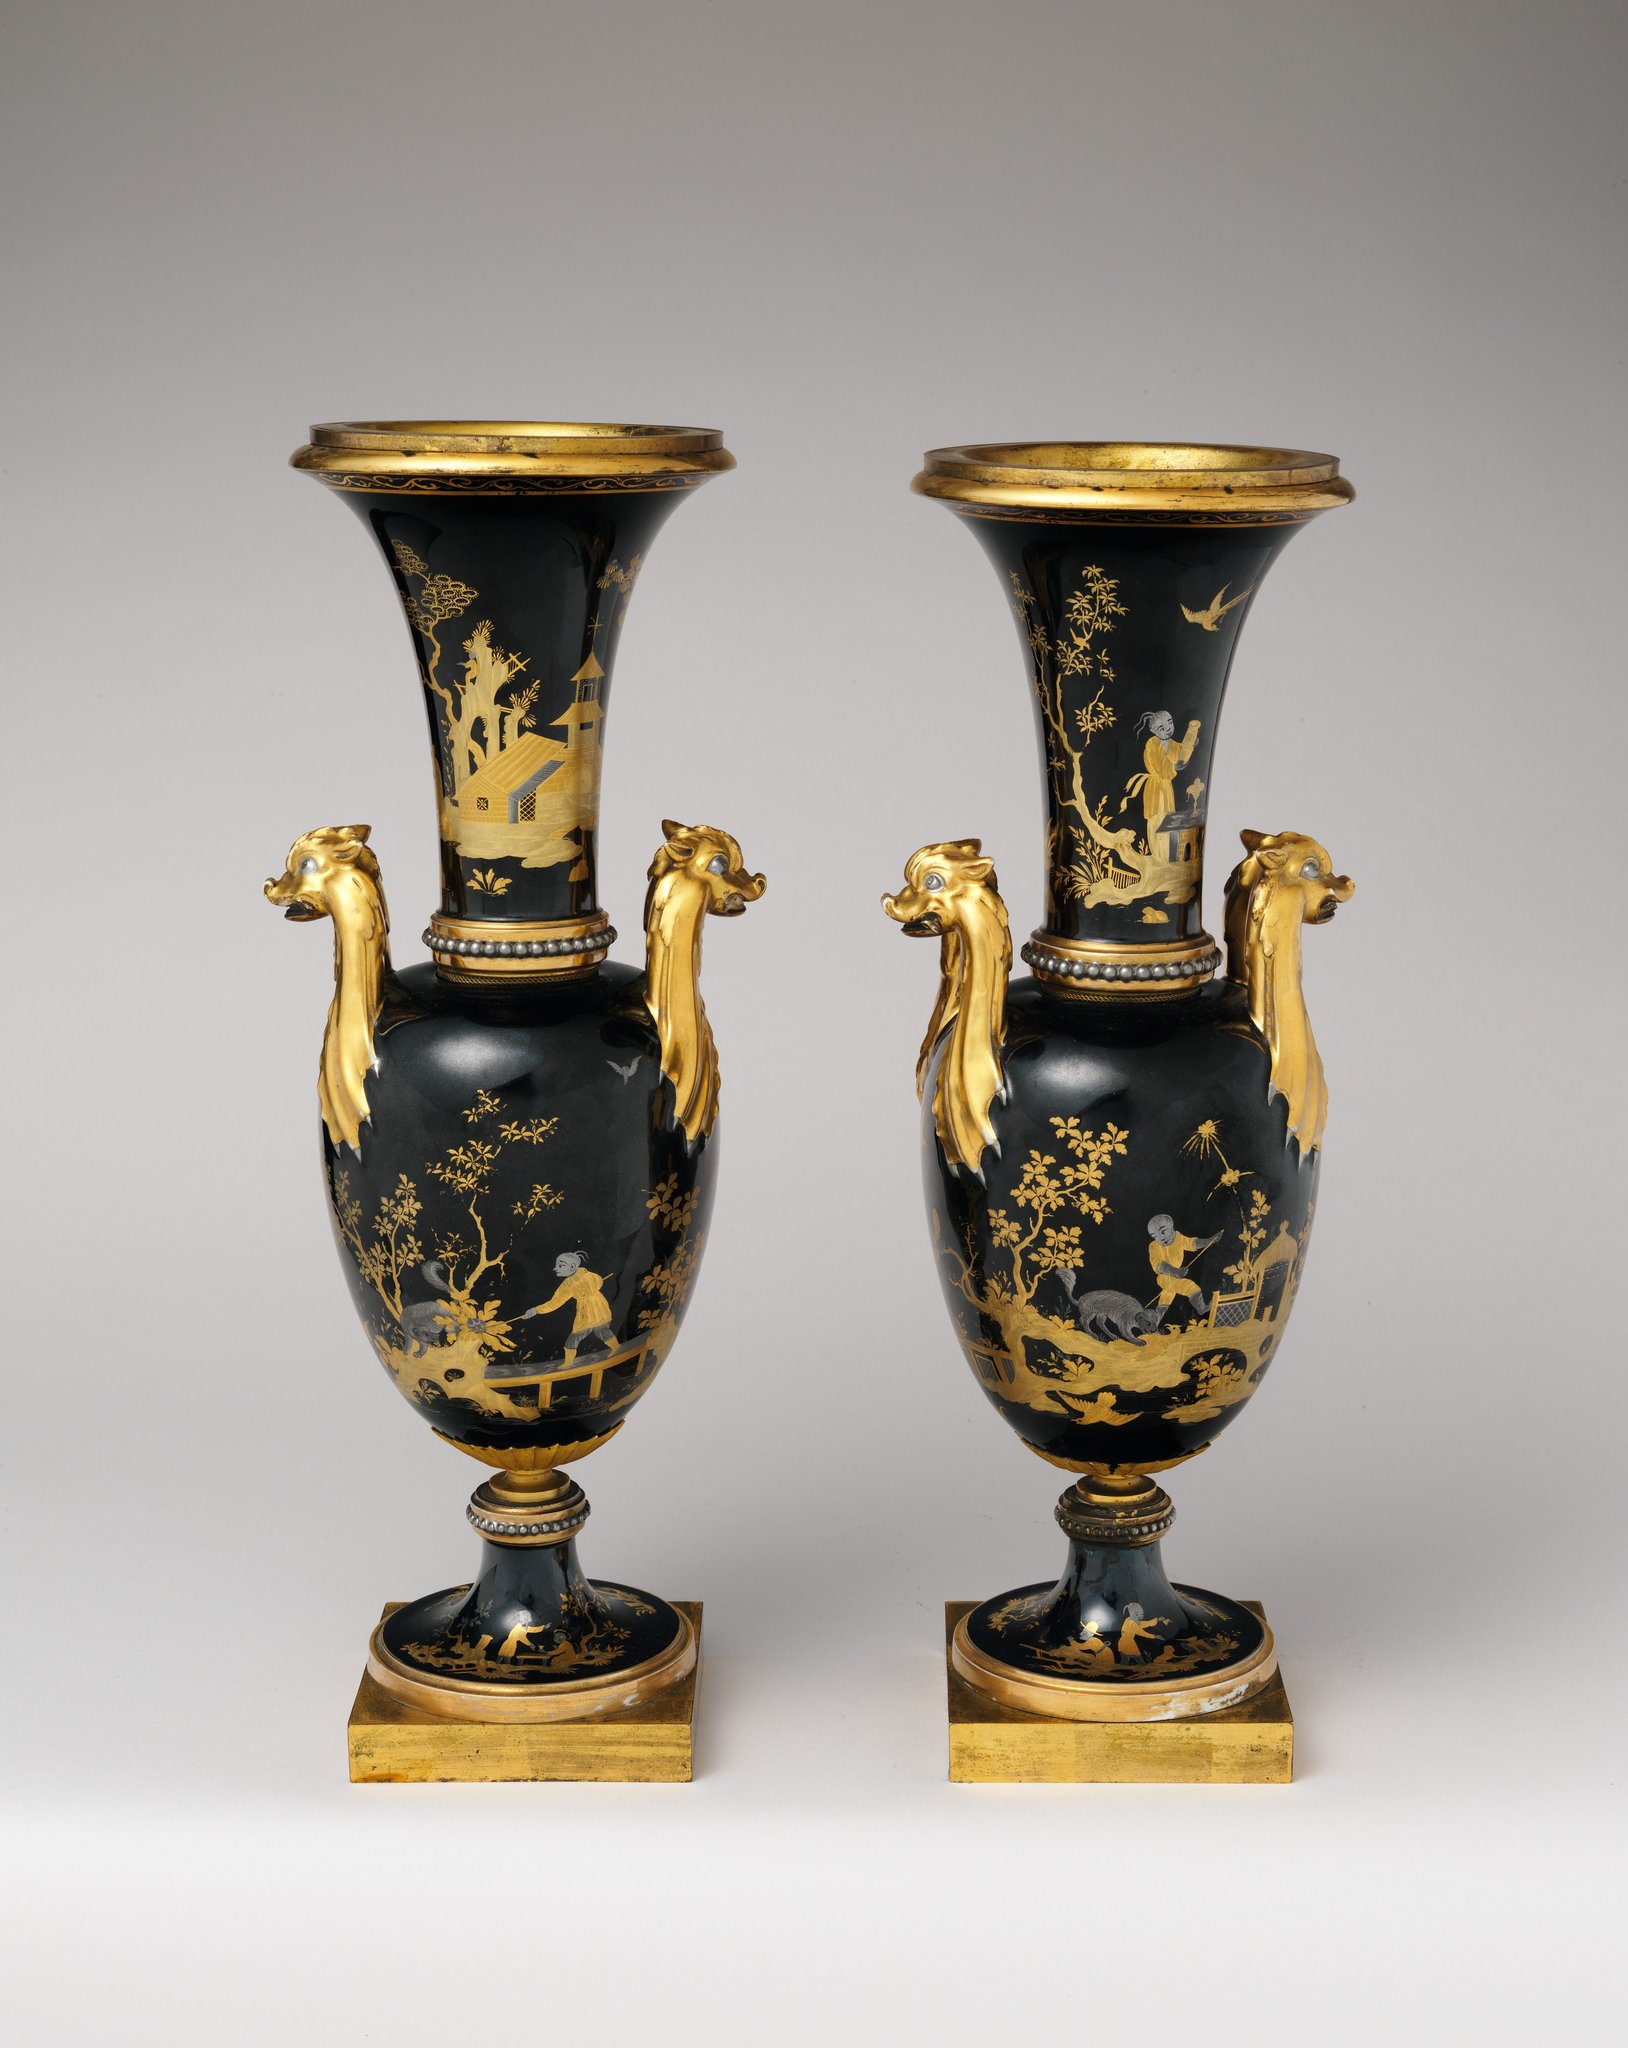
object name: vase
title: Vase (vase chinois) (one of a pair)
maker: sèvres manufactory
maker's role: manufactory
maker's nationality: french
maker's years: 1740-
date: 1791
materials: enamel, gilt, gold, hard paste porcelain, metal, platinum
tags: animals,birds,chinoiserie,men